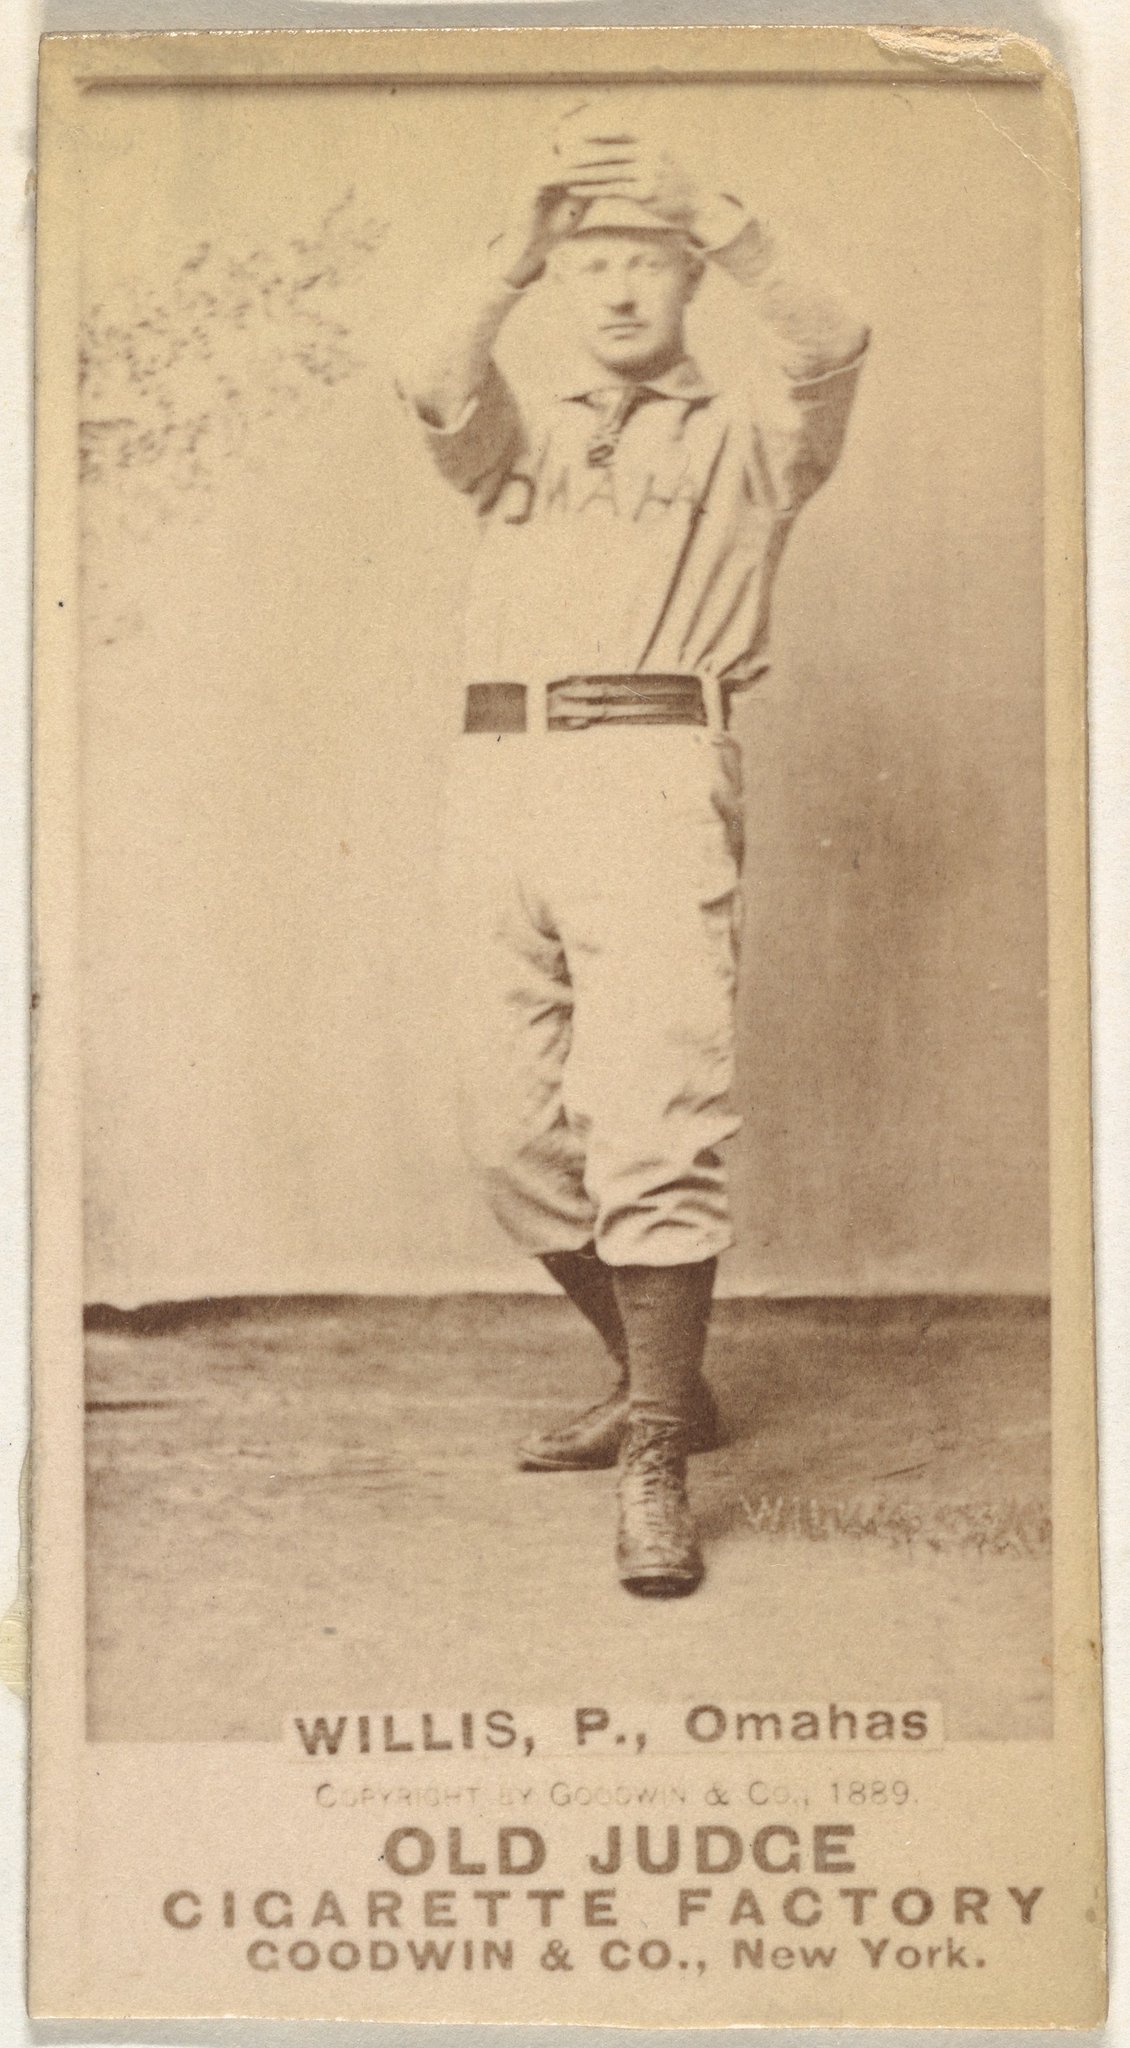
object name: baseball card, photograph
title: Willis, Pitcher, Omaha Omahogs/ Lambs, from the Old Judge series (N172) for Old Judge Cigarettes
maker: goodwin & company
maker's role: publisher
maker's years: 1850-1950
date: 1889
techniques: albumen silver print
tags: men,portraits,baseball,athletes